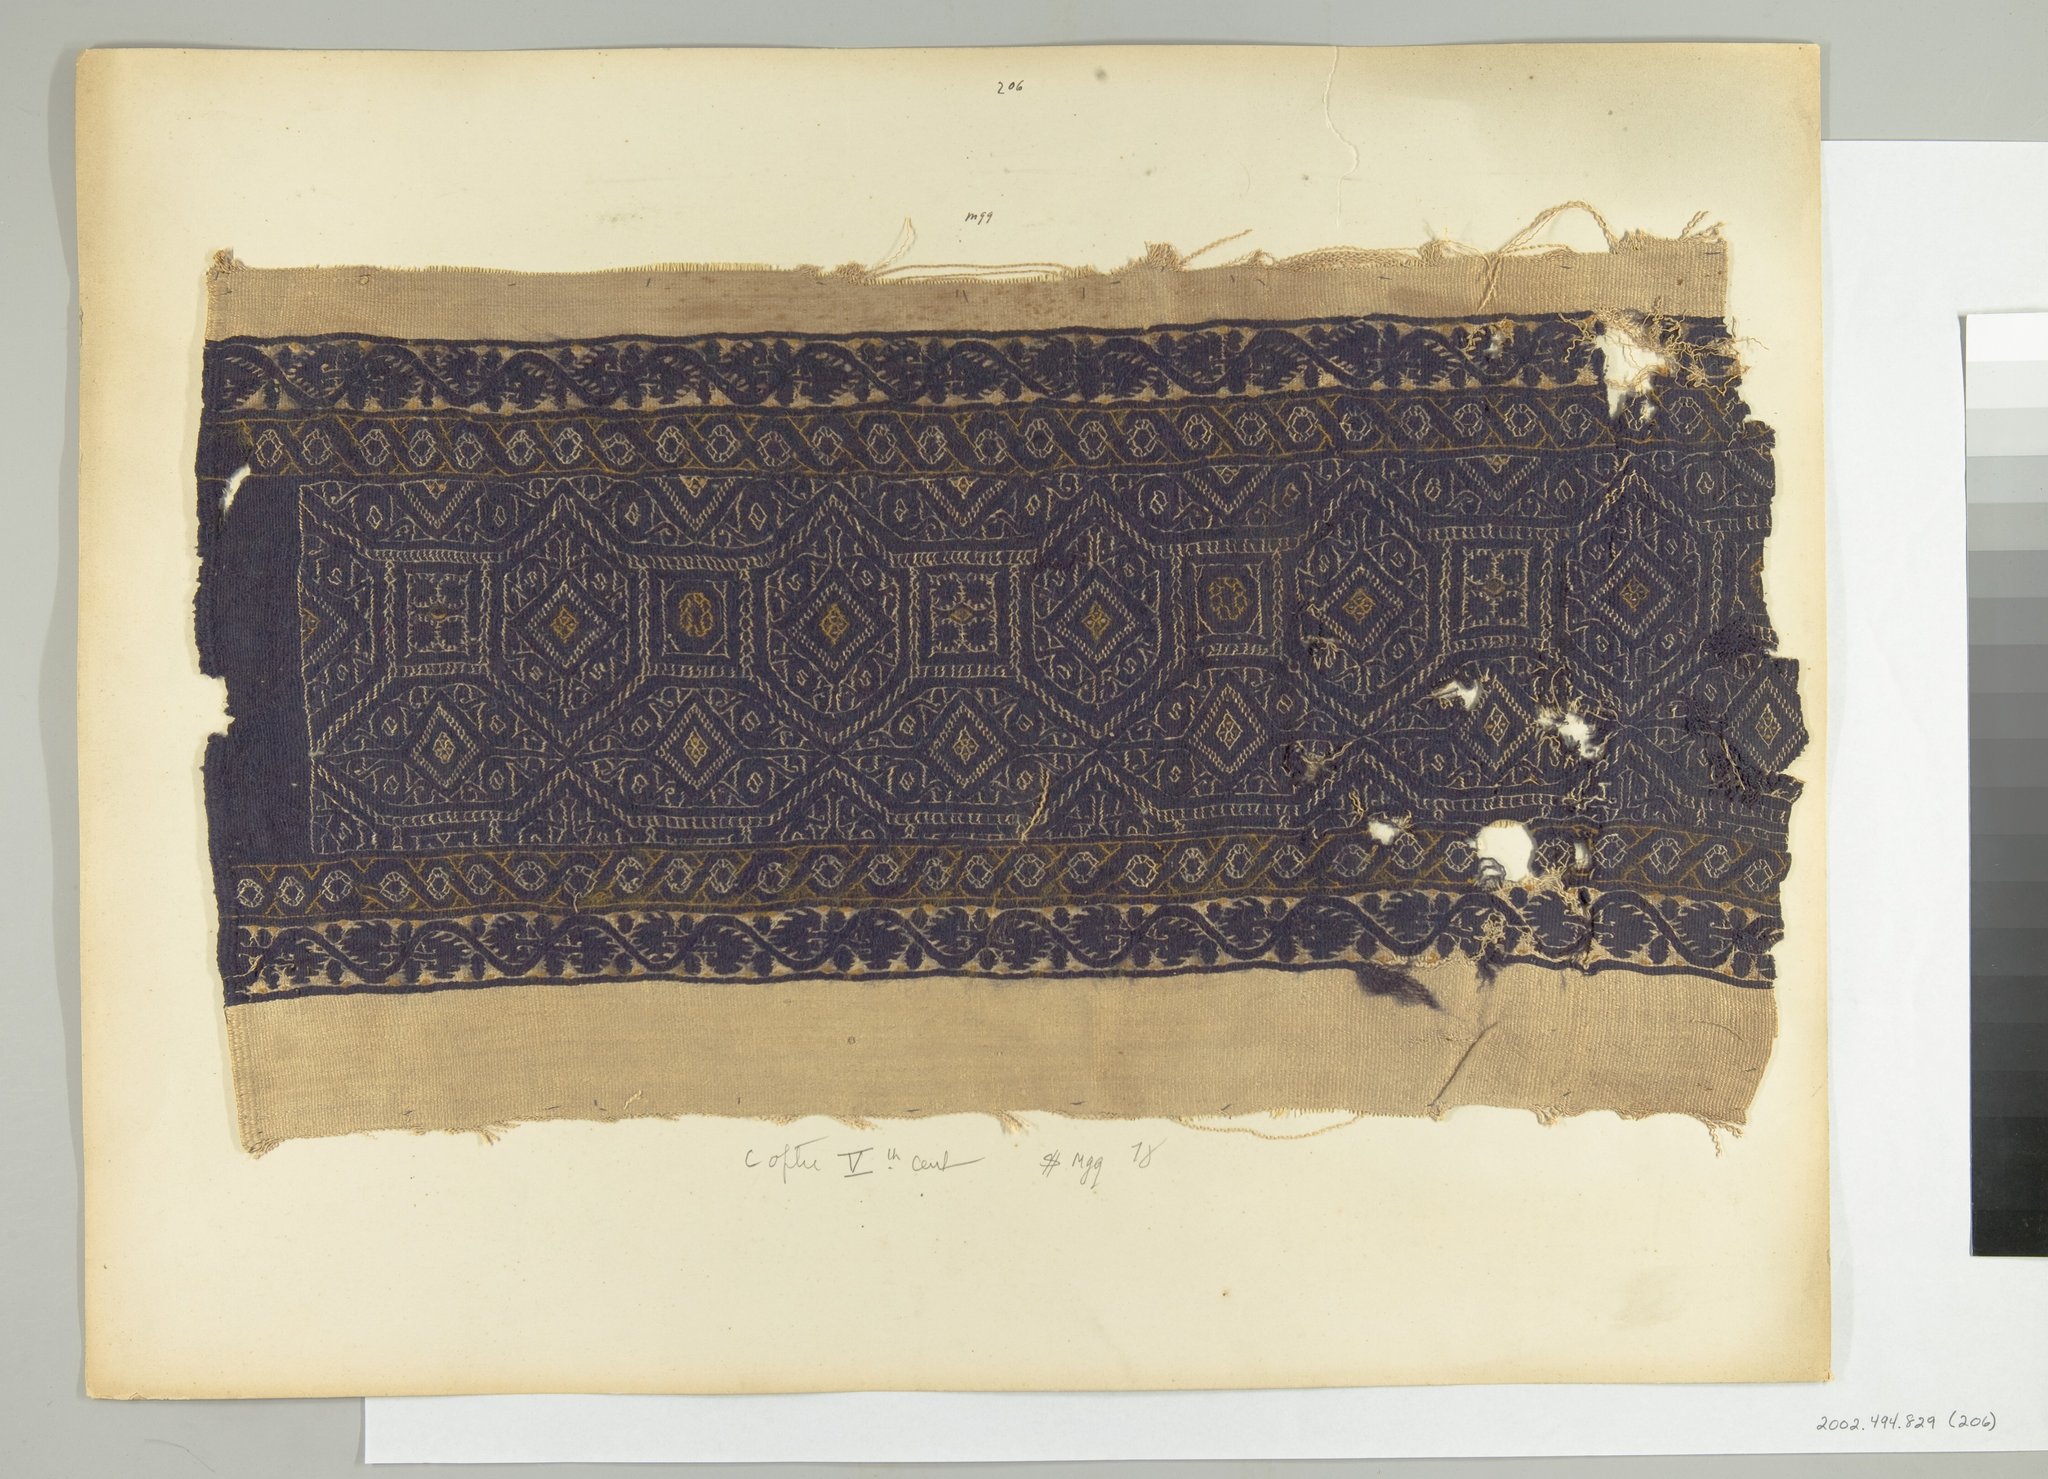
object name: textile fragment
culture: coptic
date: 401-600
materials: linen, wool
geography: egypt